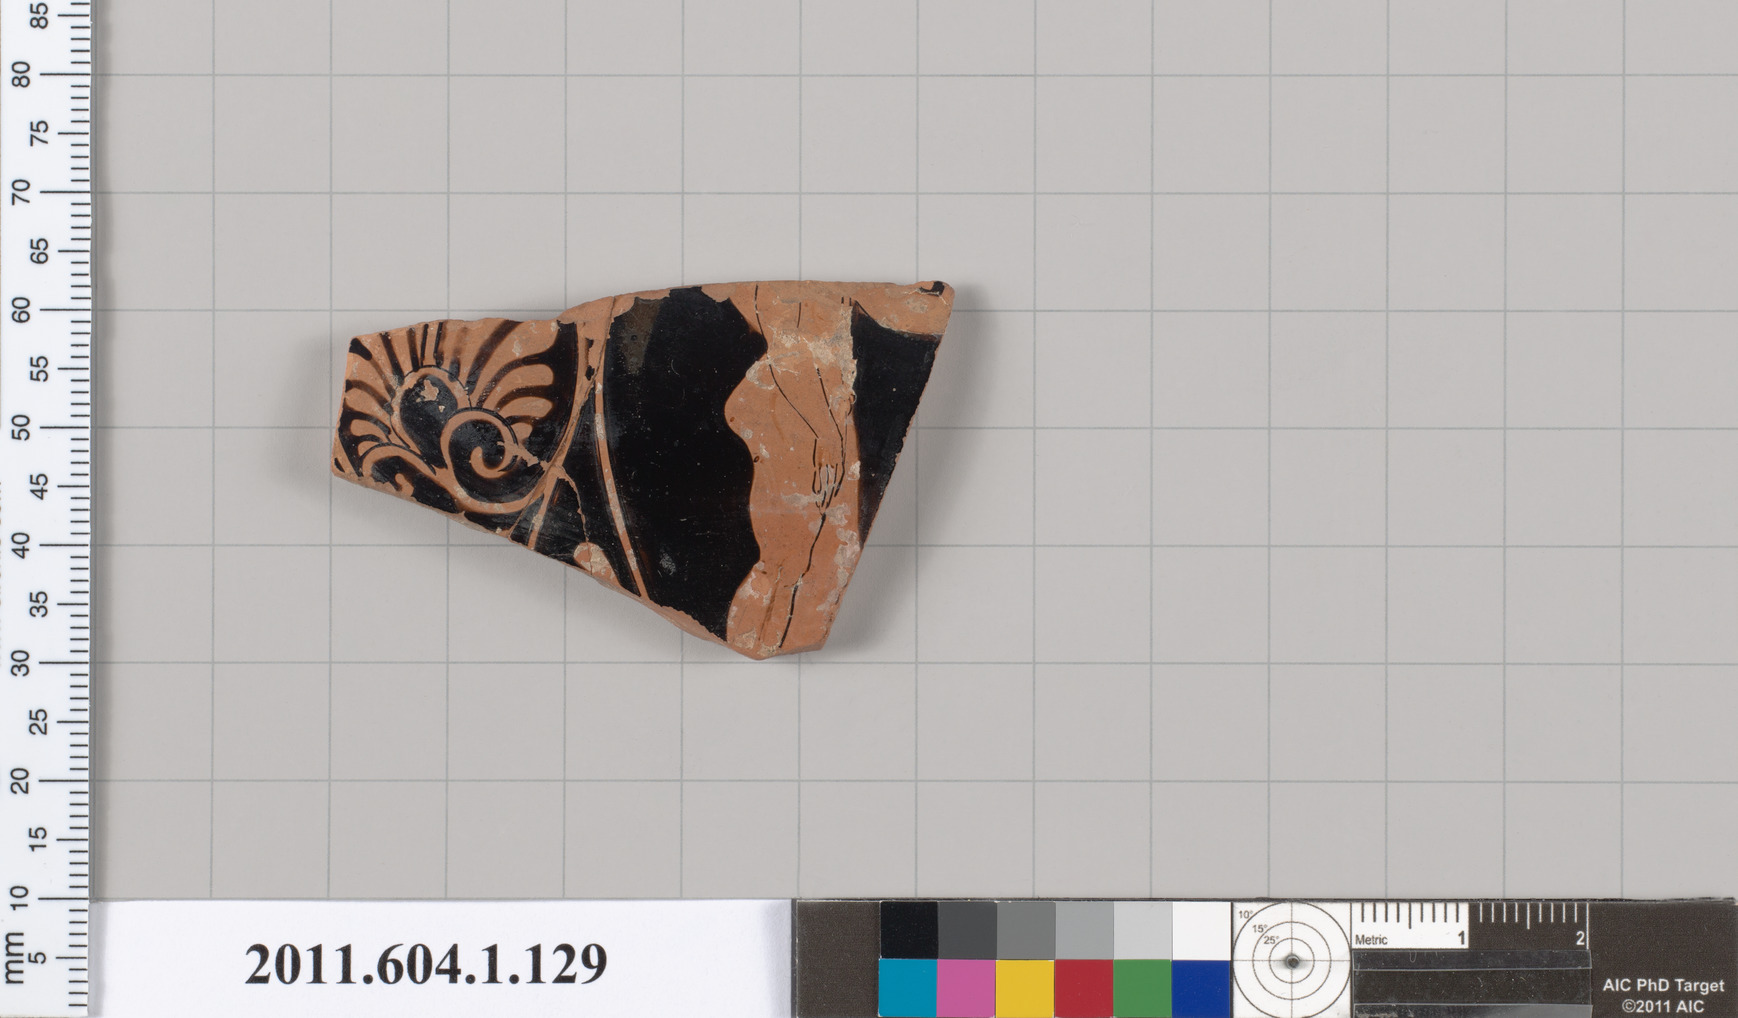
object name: kylix fragment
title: Terracotta fragment of a kylix (drinking cup)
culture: greek, attic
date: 475-451 BCE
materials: terracotta